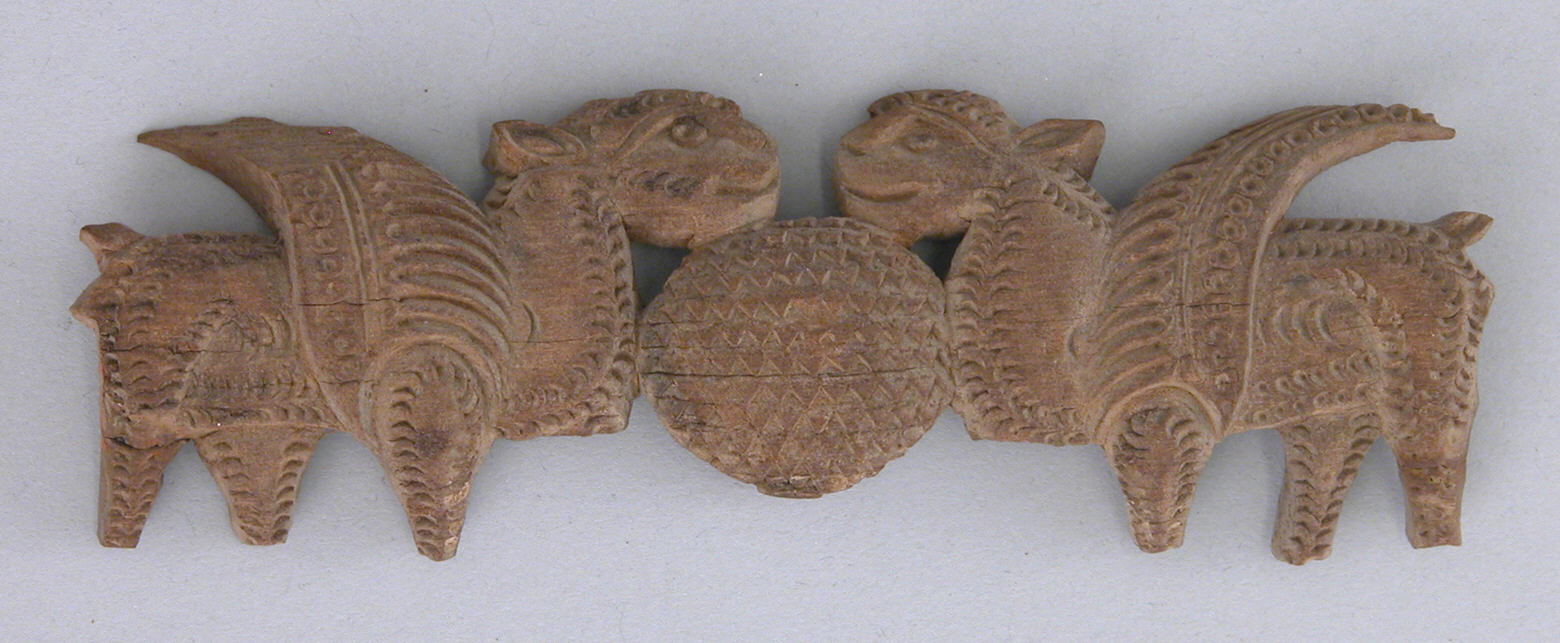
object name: panel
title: Two Winged Beasts Confronted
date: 901-1200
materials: wood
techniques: carving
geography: iraq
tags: mythical creatures